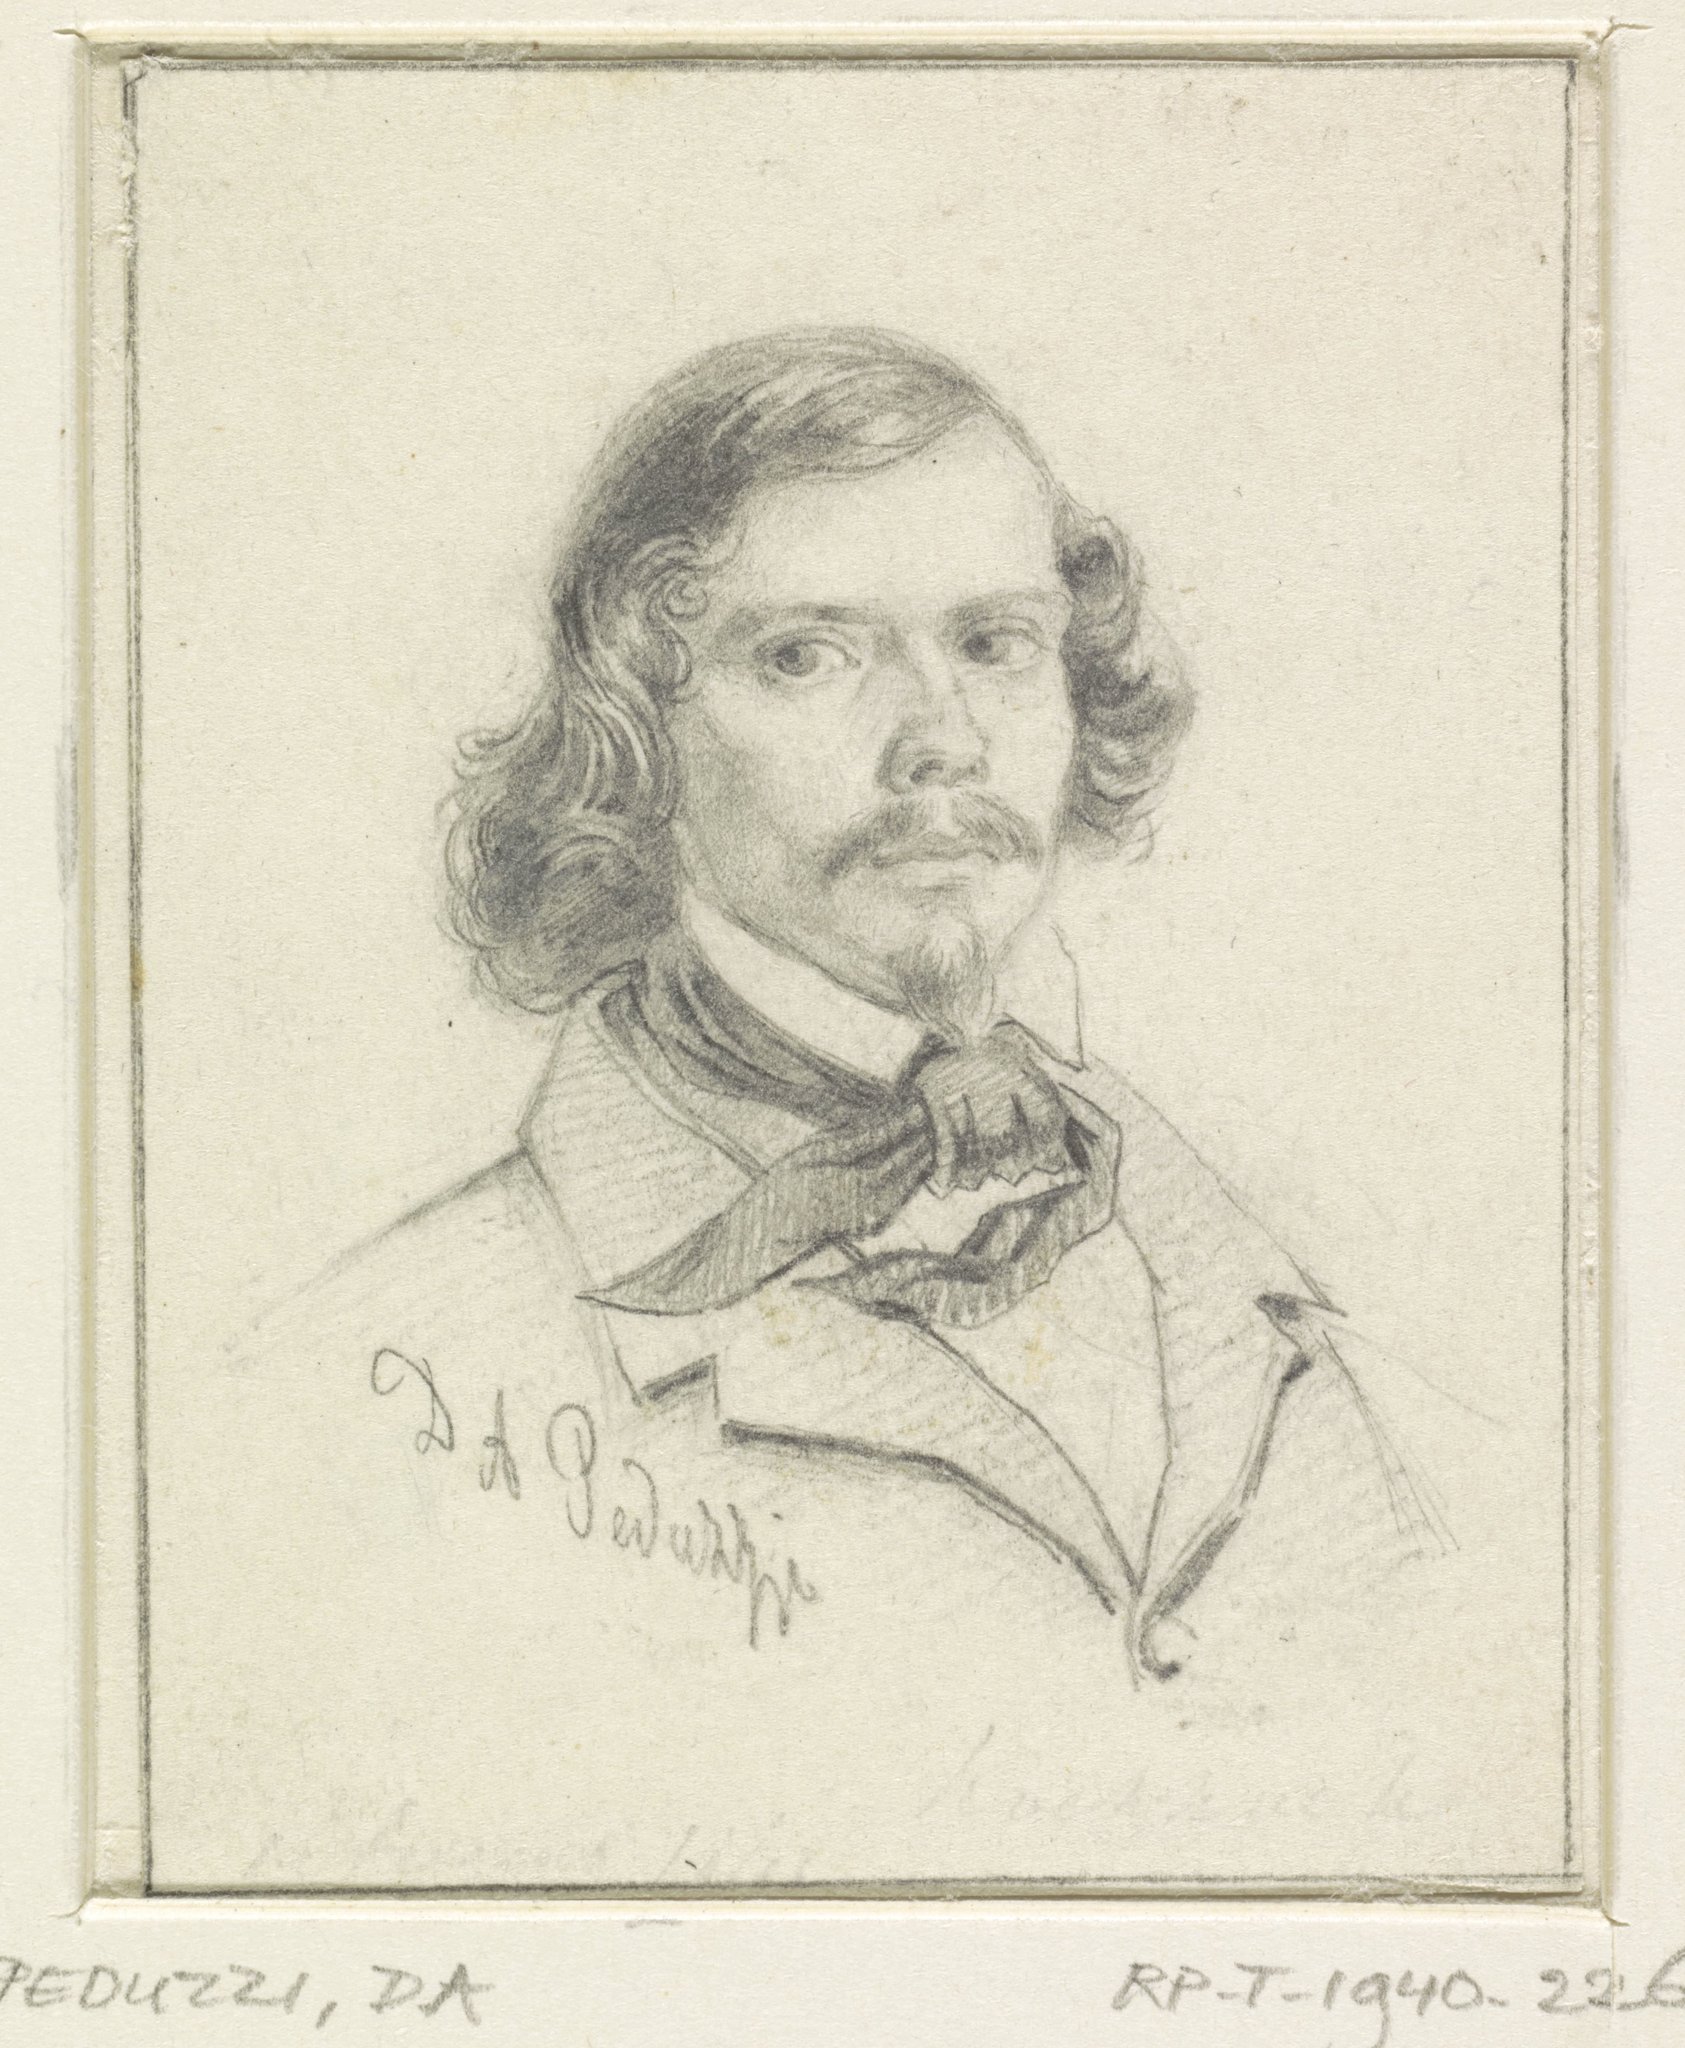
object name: drawing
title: Portret van Hermanus Koekkoek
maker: dominicus anthonius peduzzi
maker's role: draughtsman, print maker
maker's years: 1817-1861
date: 1827-1861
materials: paper, pencil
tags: hermanus koekkoek (i), historical persons, portrait, self-portrait of painter, portrait, self-portrait of artist